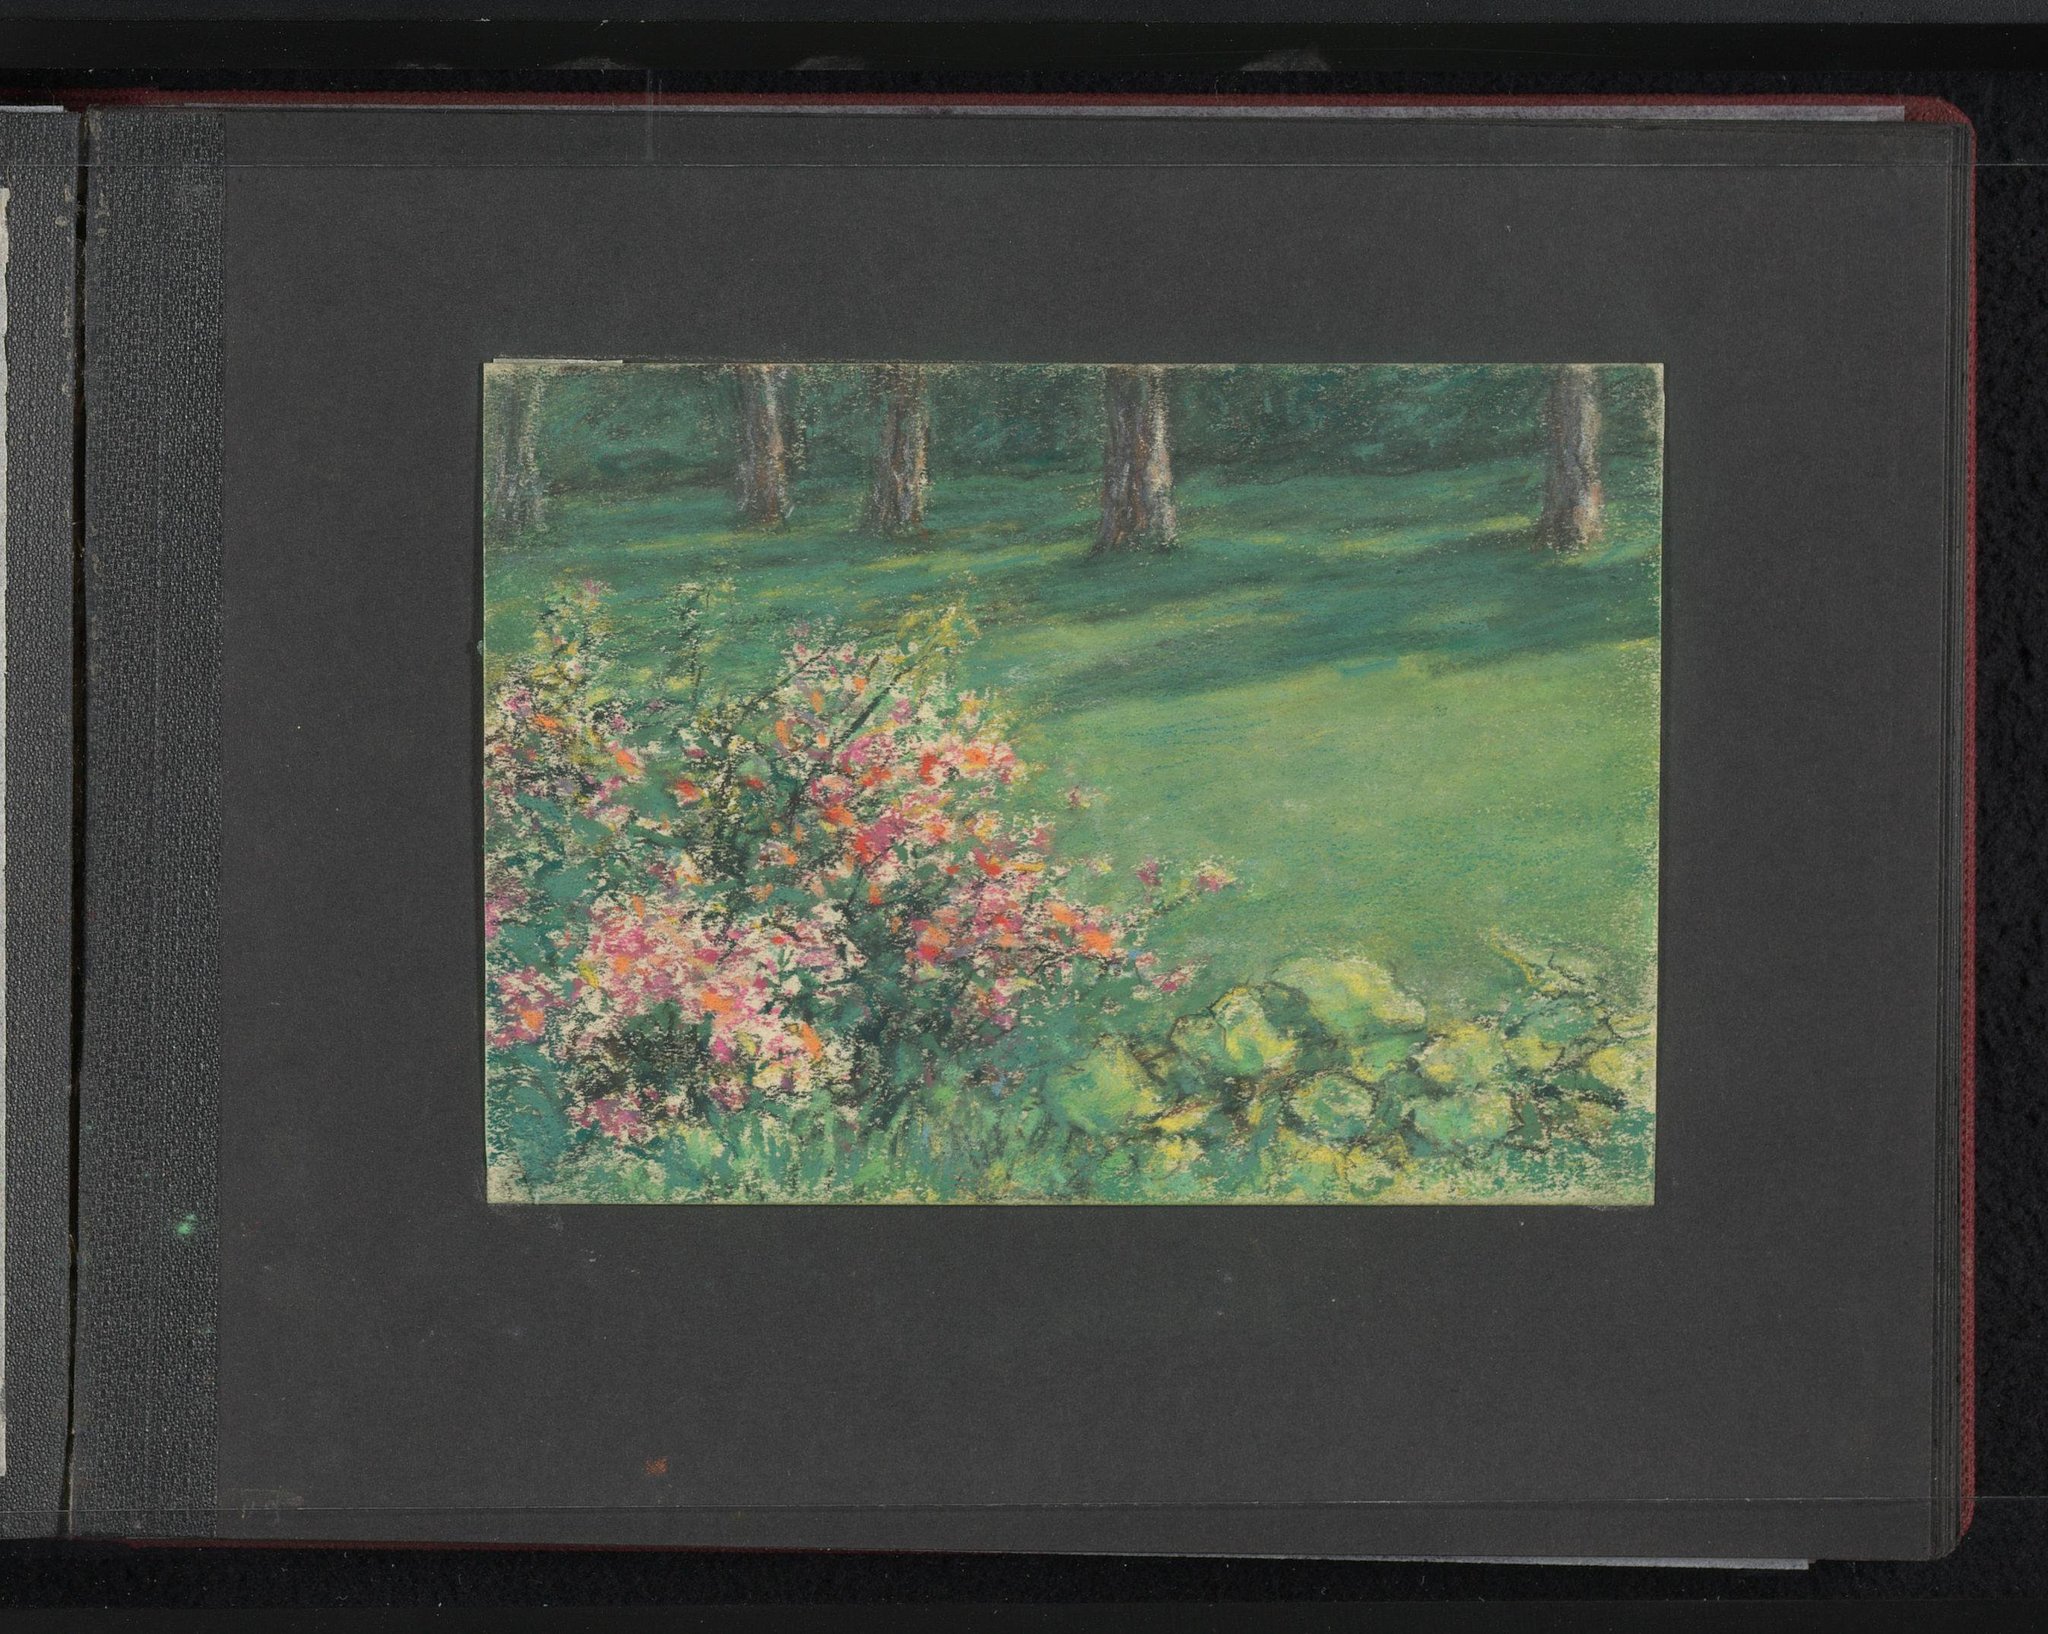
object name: drawing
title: Veld met bloemen en bomen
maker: carel nicolaas storm van s-gravesande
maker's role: draughtsman, print maker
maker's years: 1841-1924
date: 1915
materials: chalk, paper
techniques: pasting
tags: flowers, trees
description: Mogelijk in het Kurpark te Wiesbaden. Tekening maakt deel uit van een album.